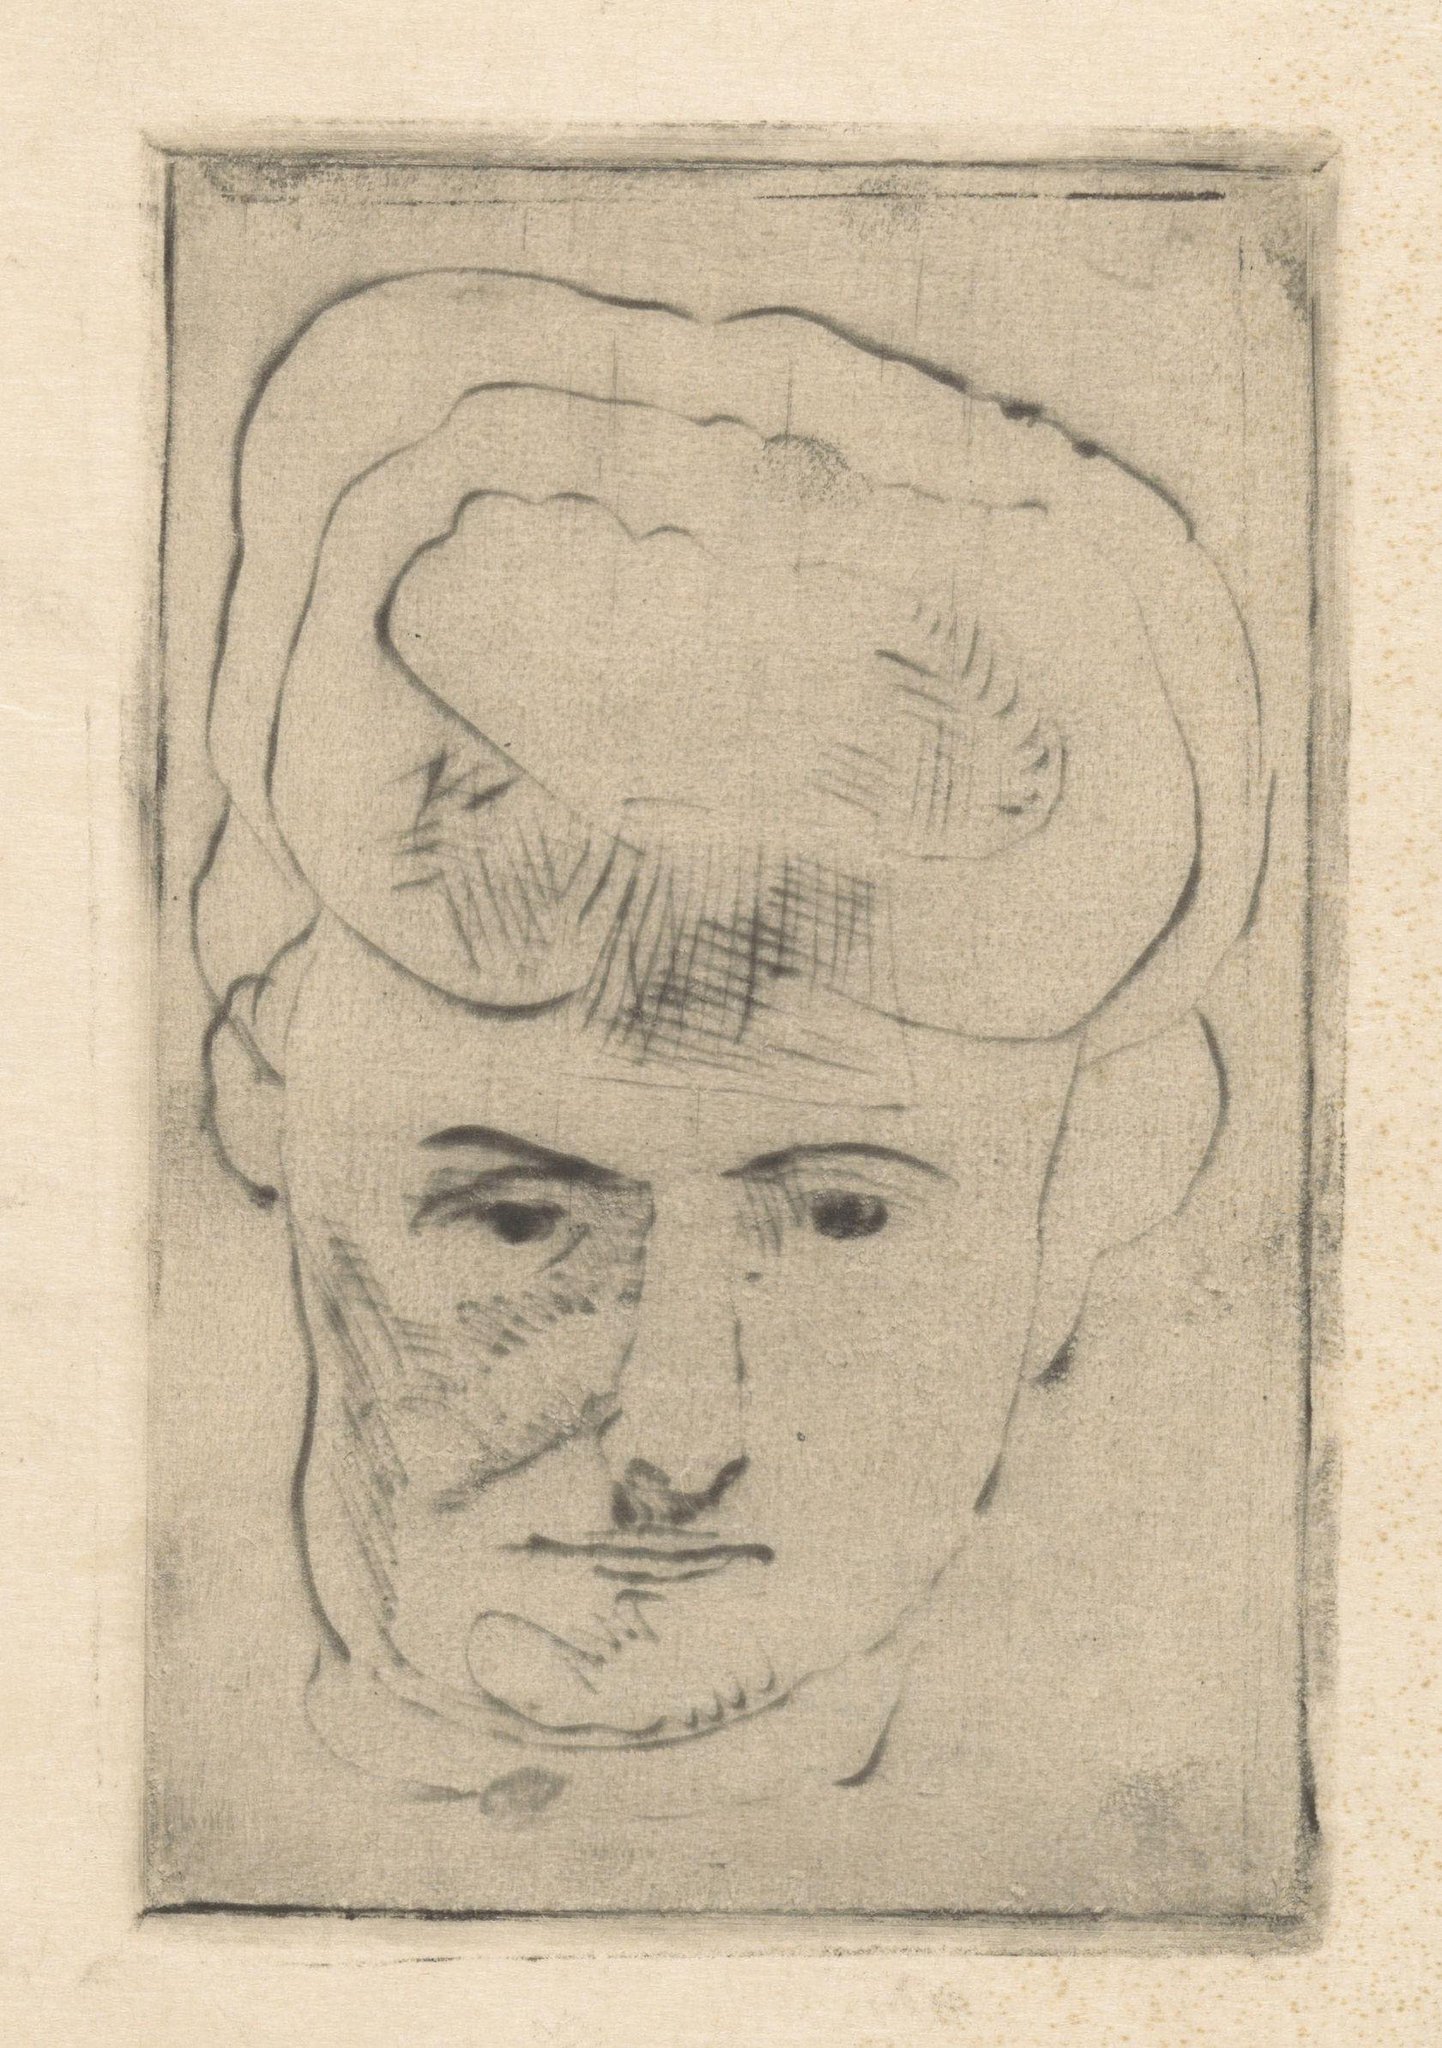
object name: print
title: Naar beneden kijkende man met muts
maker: marius holleman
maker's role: draughtsman, print maker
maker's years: 1878-1926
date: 1904-1926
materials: paper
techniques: etching, intaglio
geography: groningen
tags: head-gear: hat, looking downwards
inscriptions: collector's mark: Lugt 2228